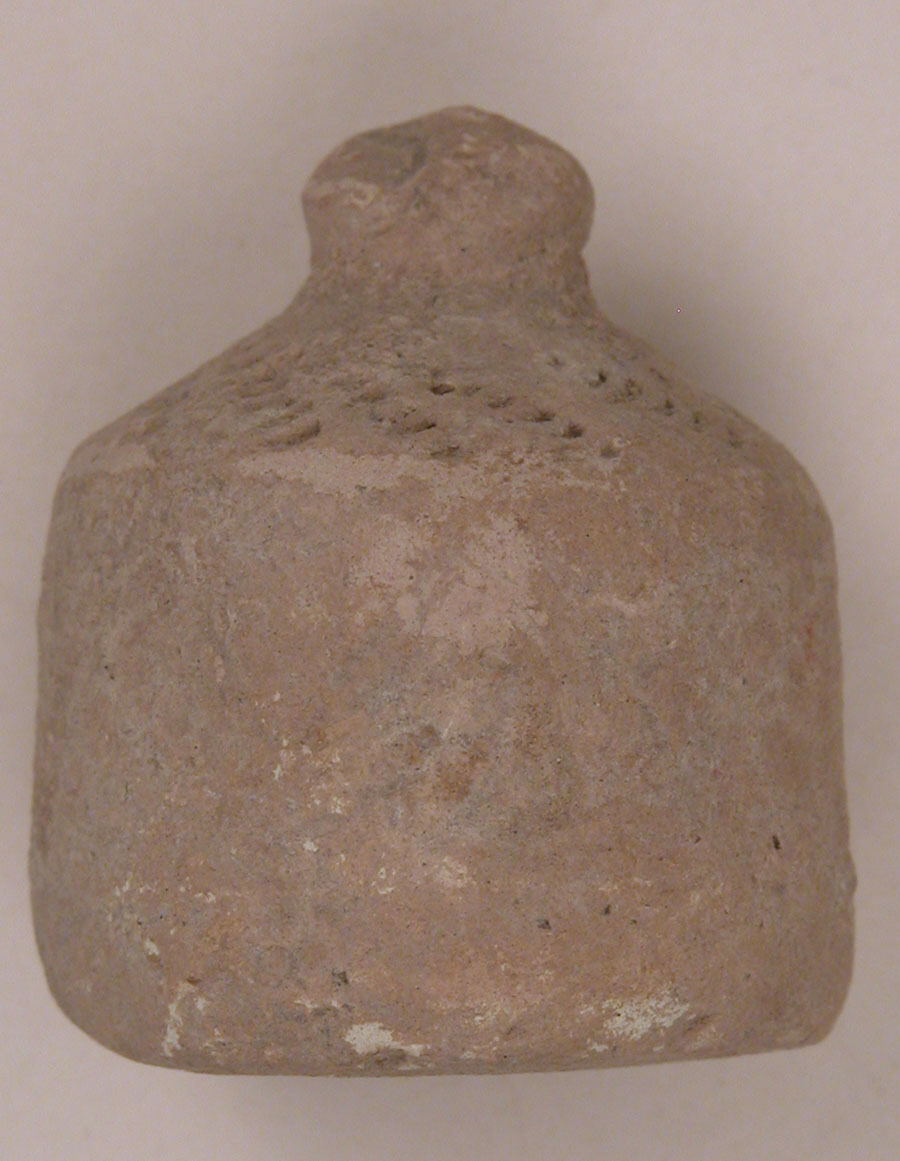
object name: chess piece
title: Chess Piece, Probably a Pawn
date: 701-1100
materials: earthenware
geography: western islamic lands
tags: chess